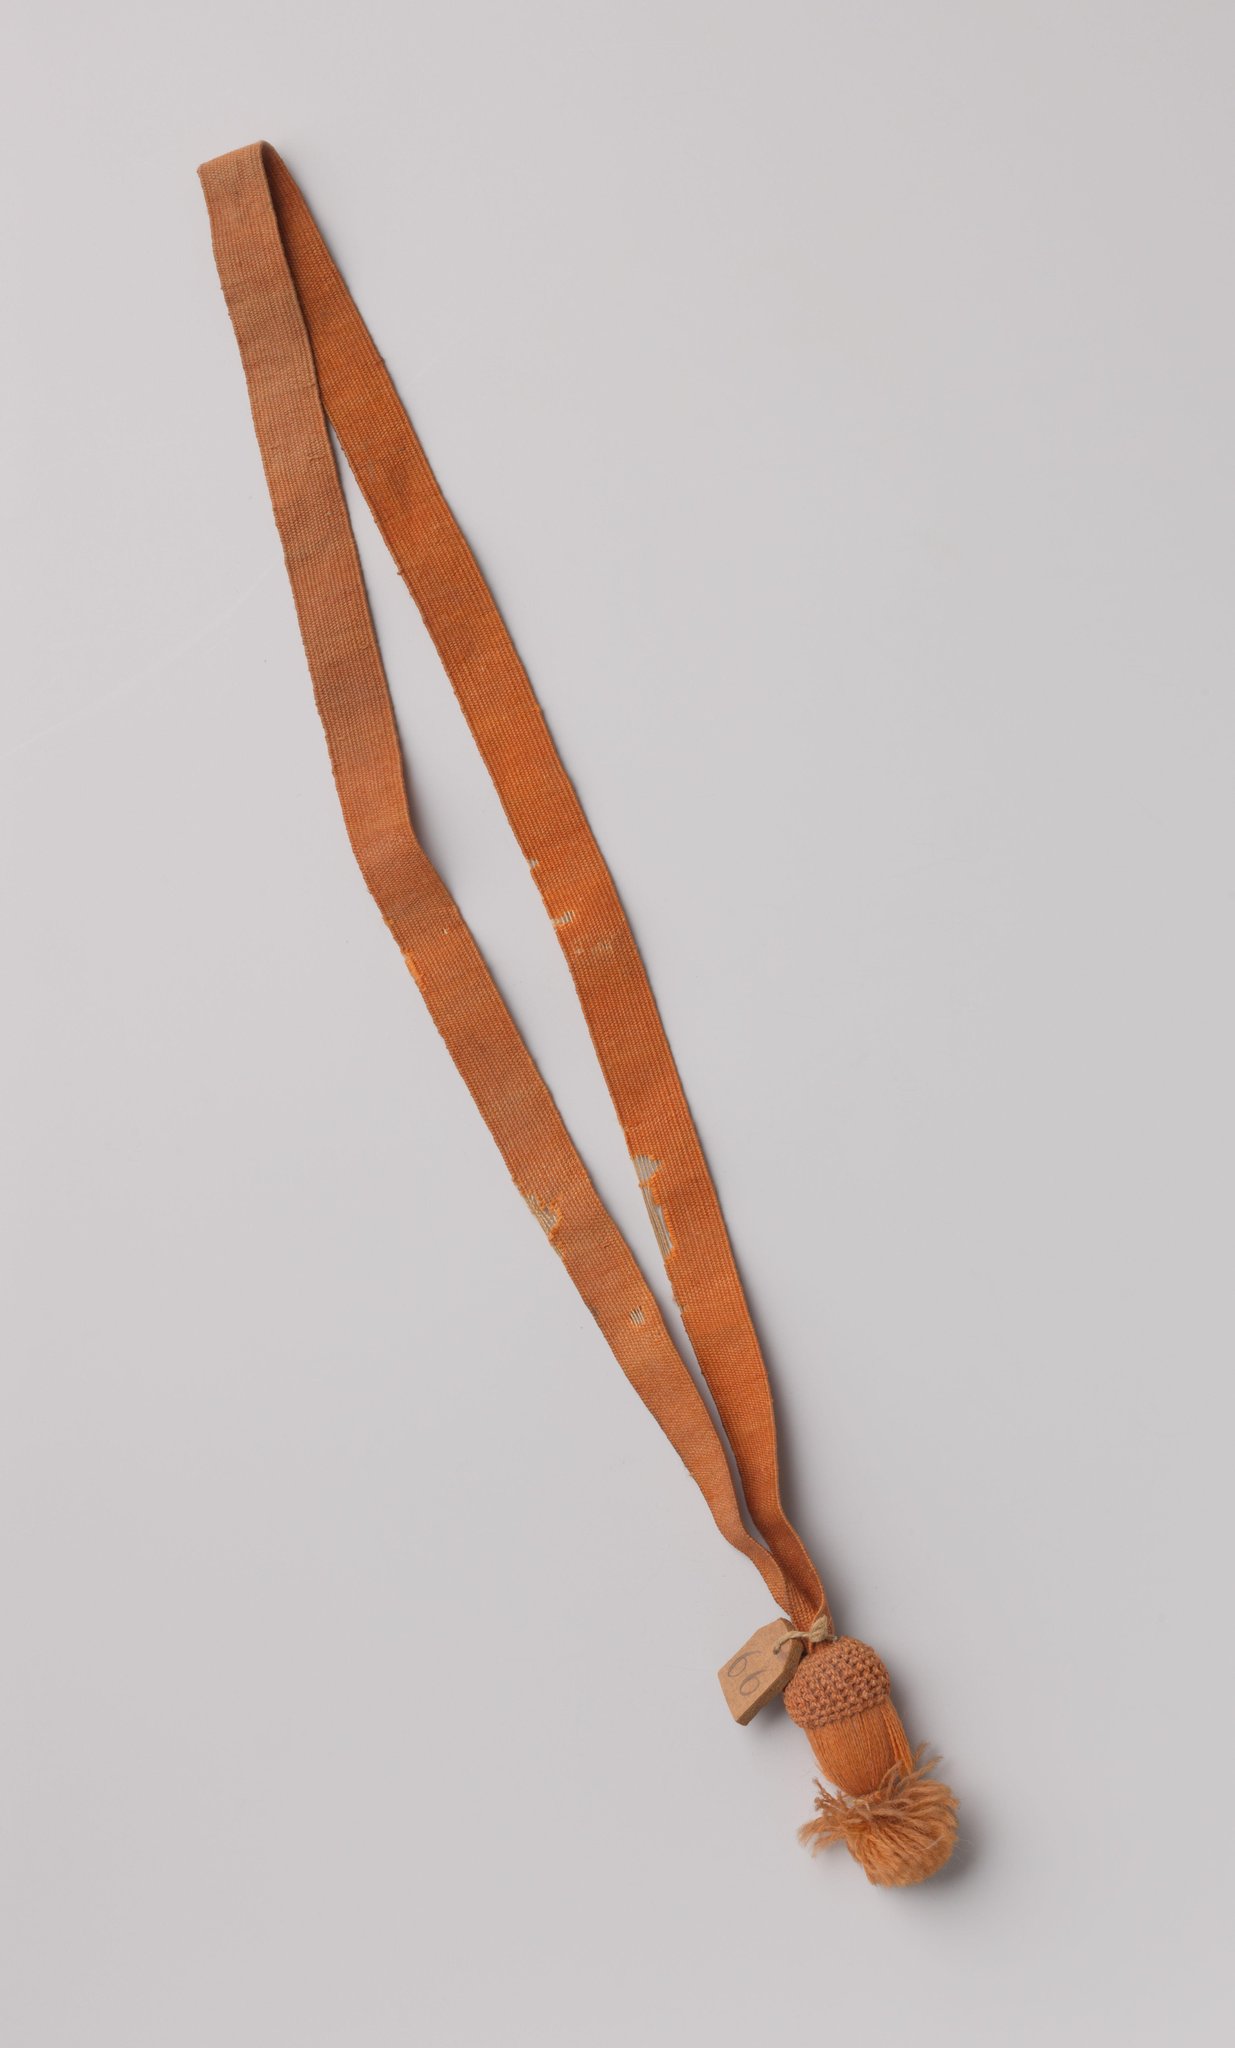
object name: porte epée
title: Dragon gedragen door J. Boelen Jkzn. in 1830/32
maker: Anonymous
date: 1800-1830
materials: textile, wool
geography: netherlands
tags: j. boelen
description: Oranje wollen dragon. Afkomstig van J. Boelen Jkzn., in 1830/32 Vrijwillige Flankeur, later korporaal Noord Hollandse Schutterij, 1e Afdeling 1e Bataljon.